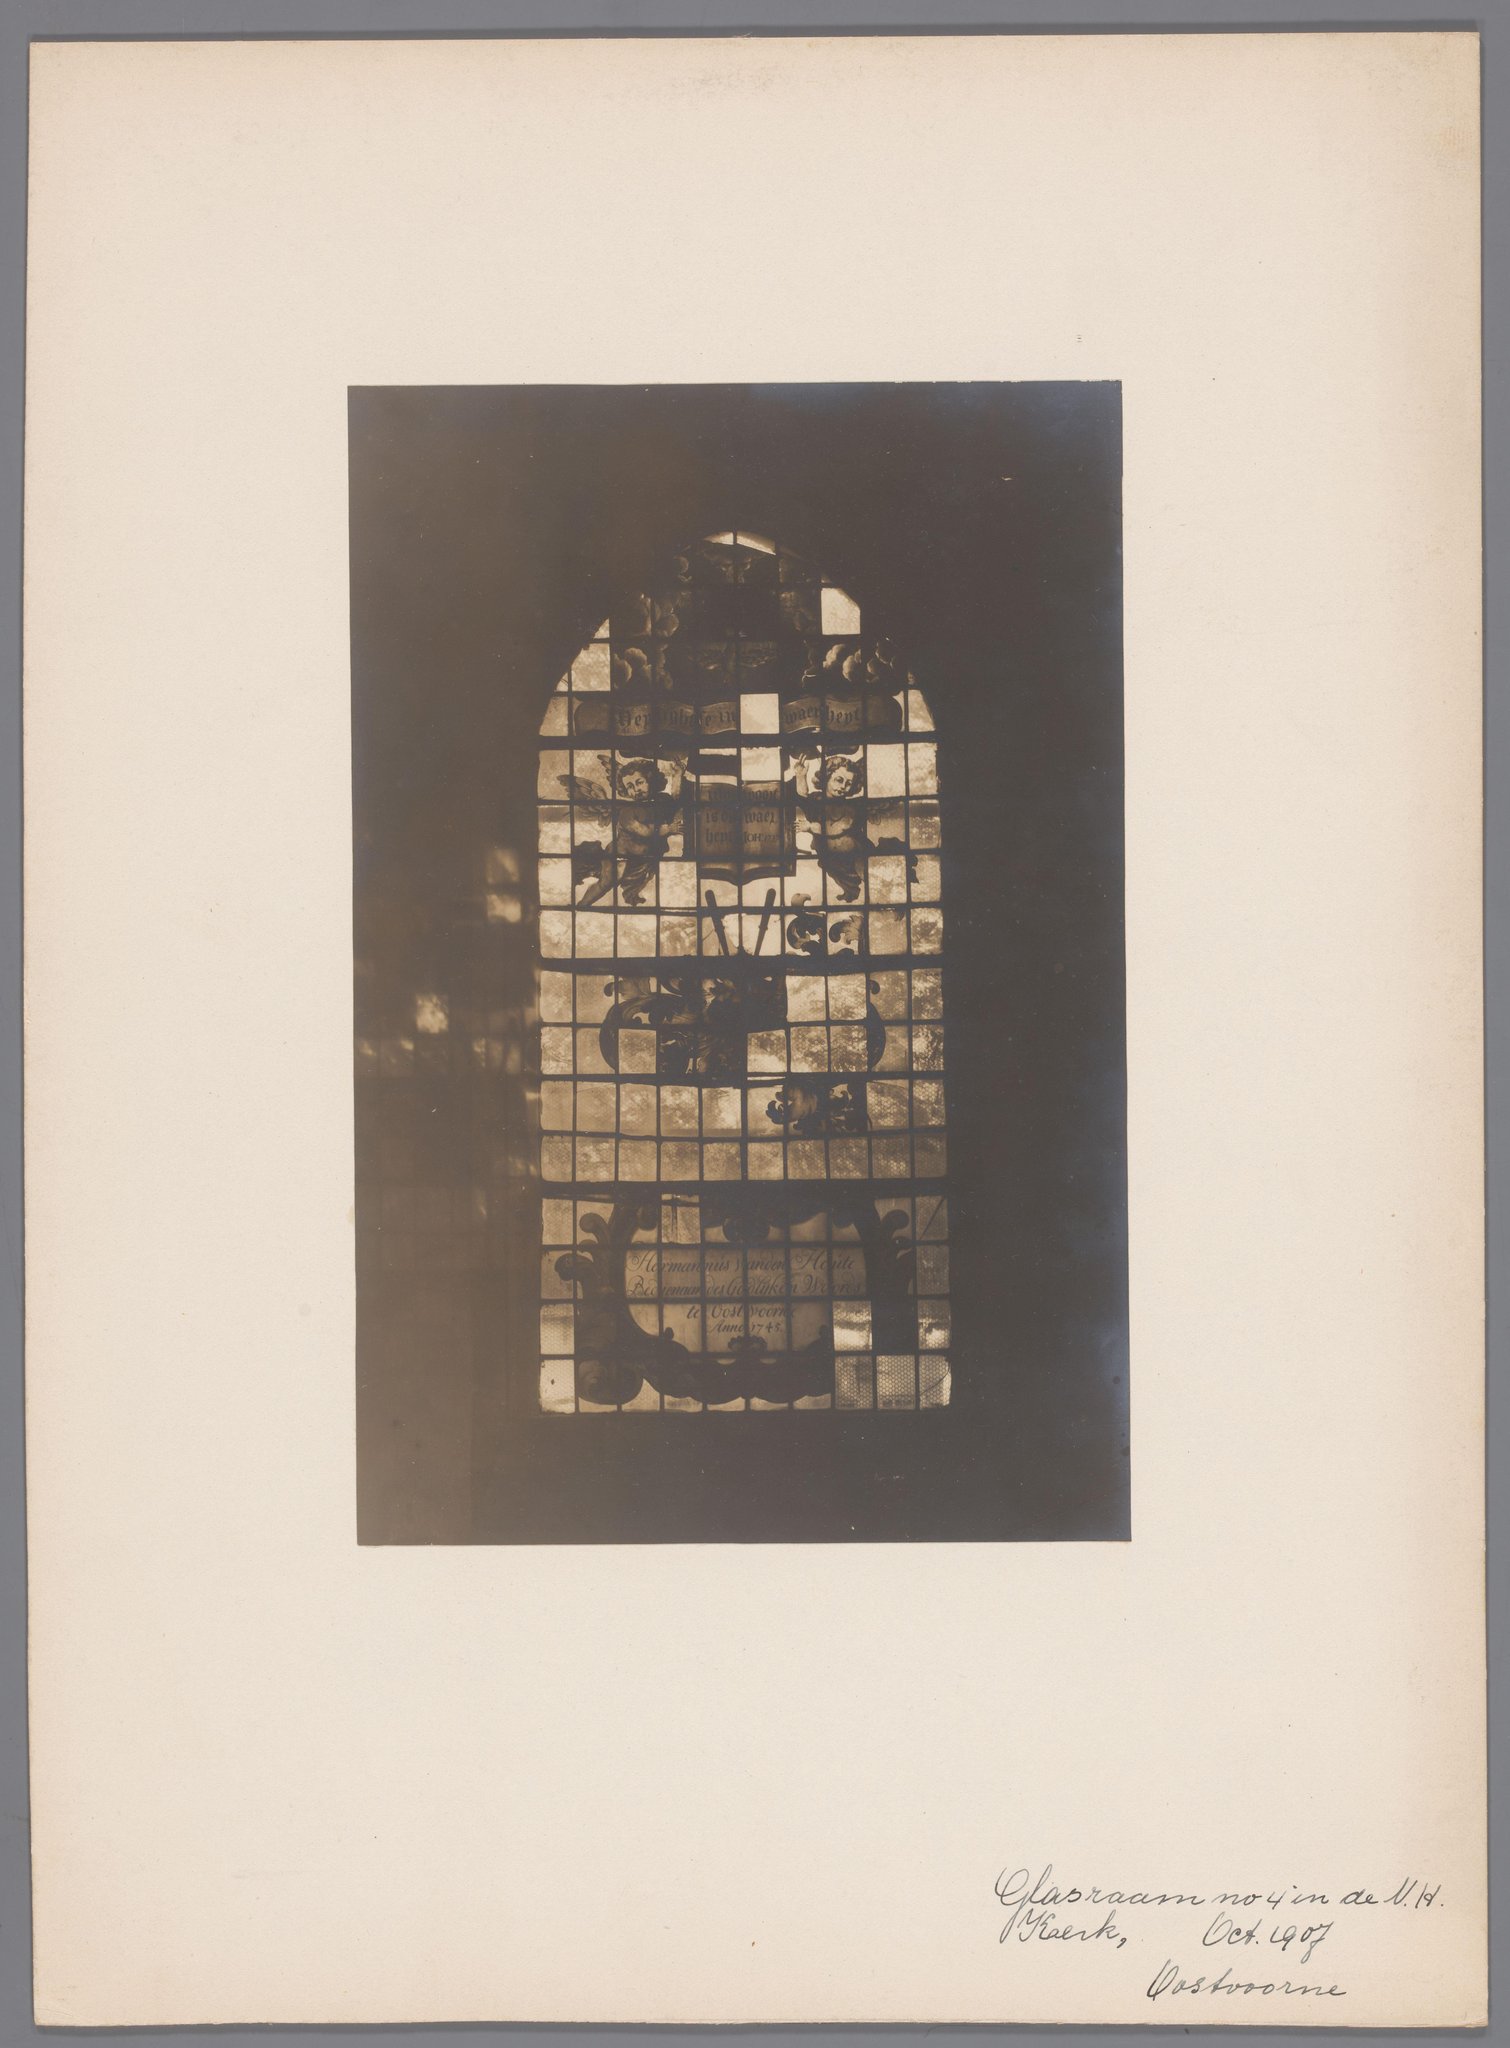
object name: photograph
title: Geschilderd raam in de Dorpskerk te Oostvoorne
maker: anoniem (monumentenzorg)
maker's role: fotograaf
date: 1907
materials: cardboard, photographic support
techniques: gelatin silver print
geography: oostvoorne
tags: church-window, e.g. rose-window, oostvoorne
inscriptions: annotation: ‘Oostvoorne (Z.H.)/ glasraam no.4 in de Ned. Herv. Kerk/ oct 1907’, annotation: ‘Glasraam no 4 in de N.H. Kerk, oct. 1907/ Oostvoorne’